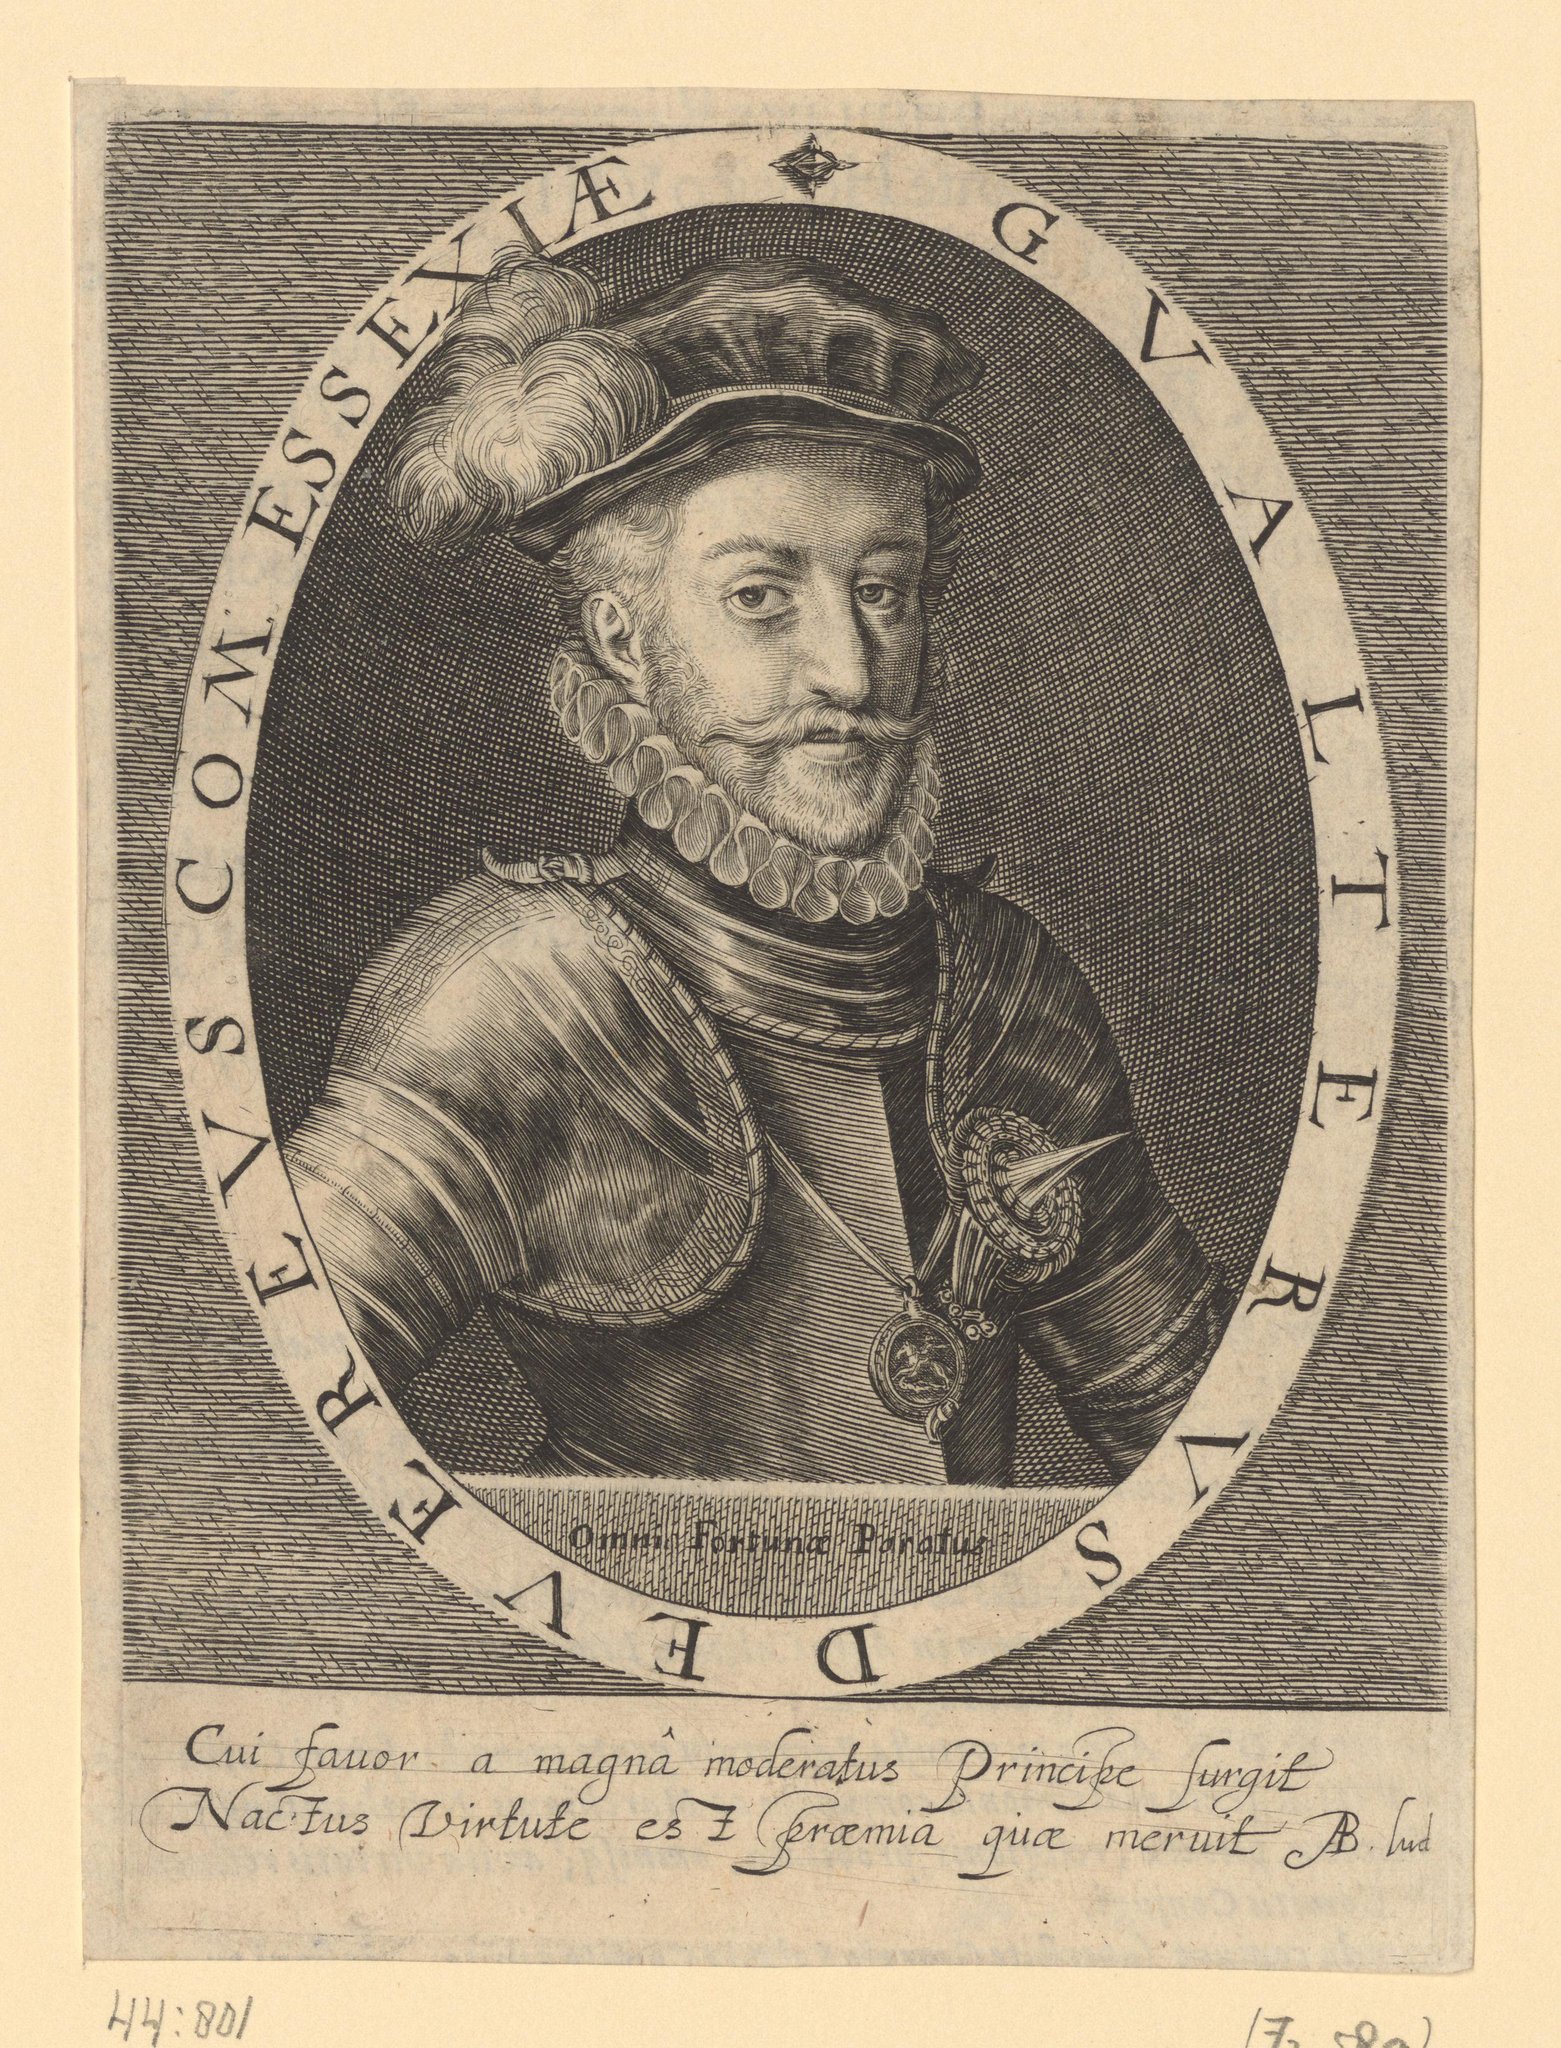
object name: print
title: Portret van Walter Devereux, graaf van Essex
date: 1620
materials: paper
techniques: engraving, letterpress printing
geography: utrecht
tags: historical persons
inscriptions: collector's mark: Lugt 2228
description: Prent uit: Holland, Henry. Heroologia Anglica (...). Utrecht: Crispijn de Passe, 1620.